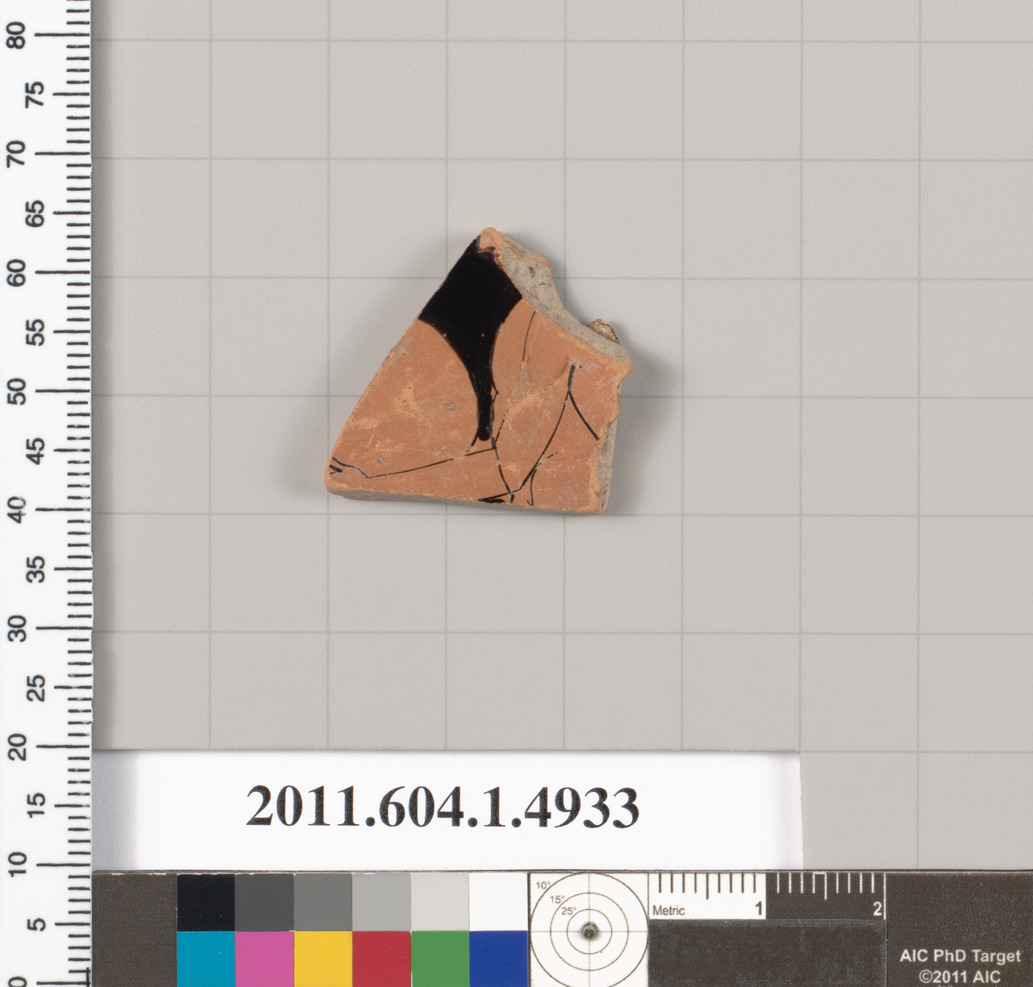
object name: kylix fragment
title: Terracotta fragment of a kylix (drinking cup)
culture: greek, attic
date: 510-490 BCE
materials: terracotta